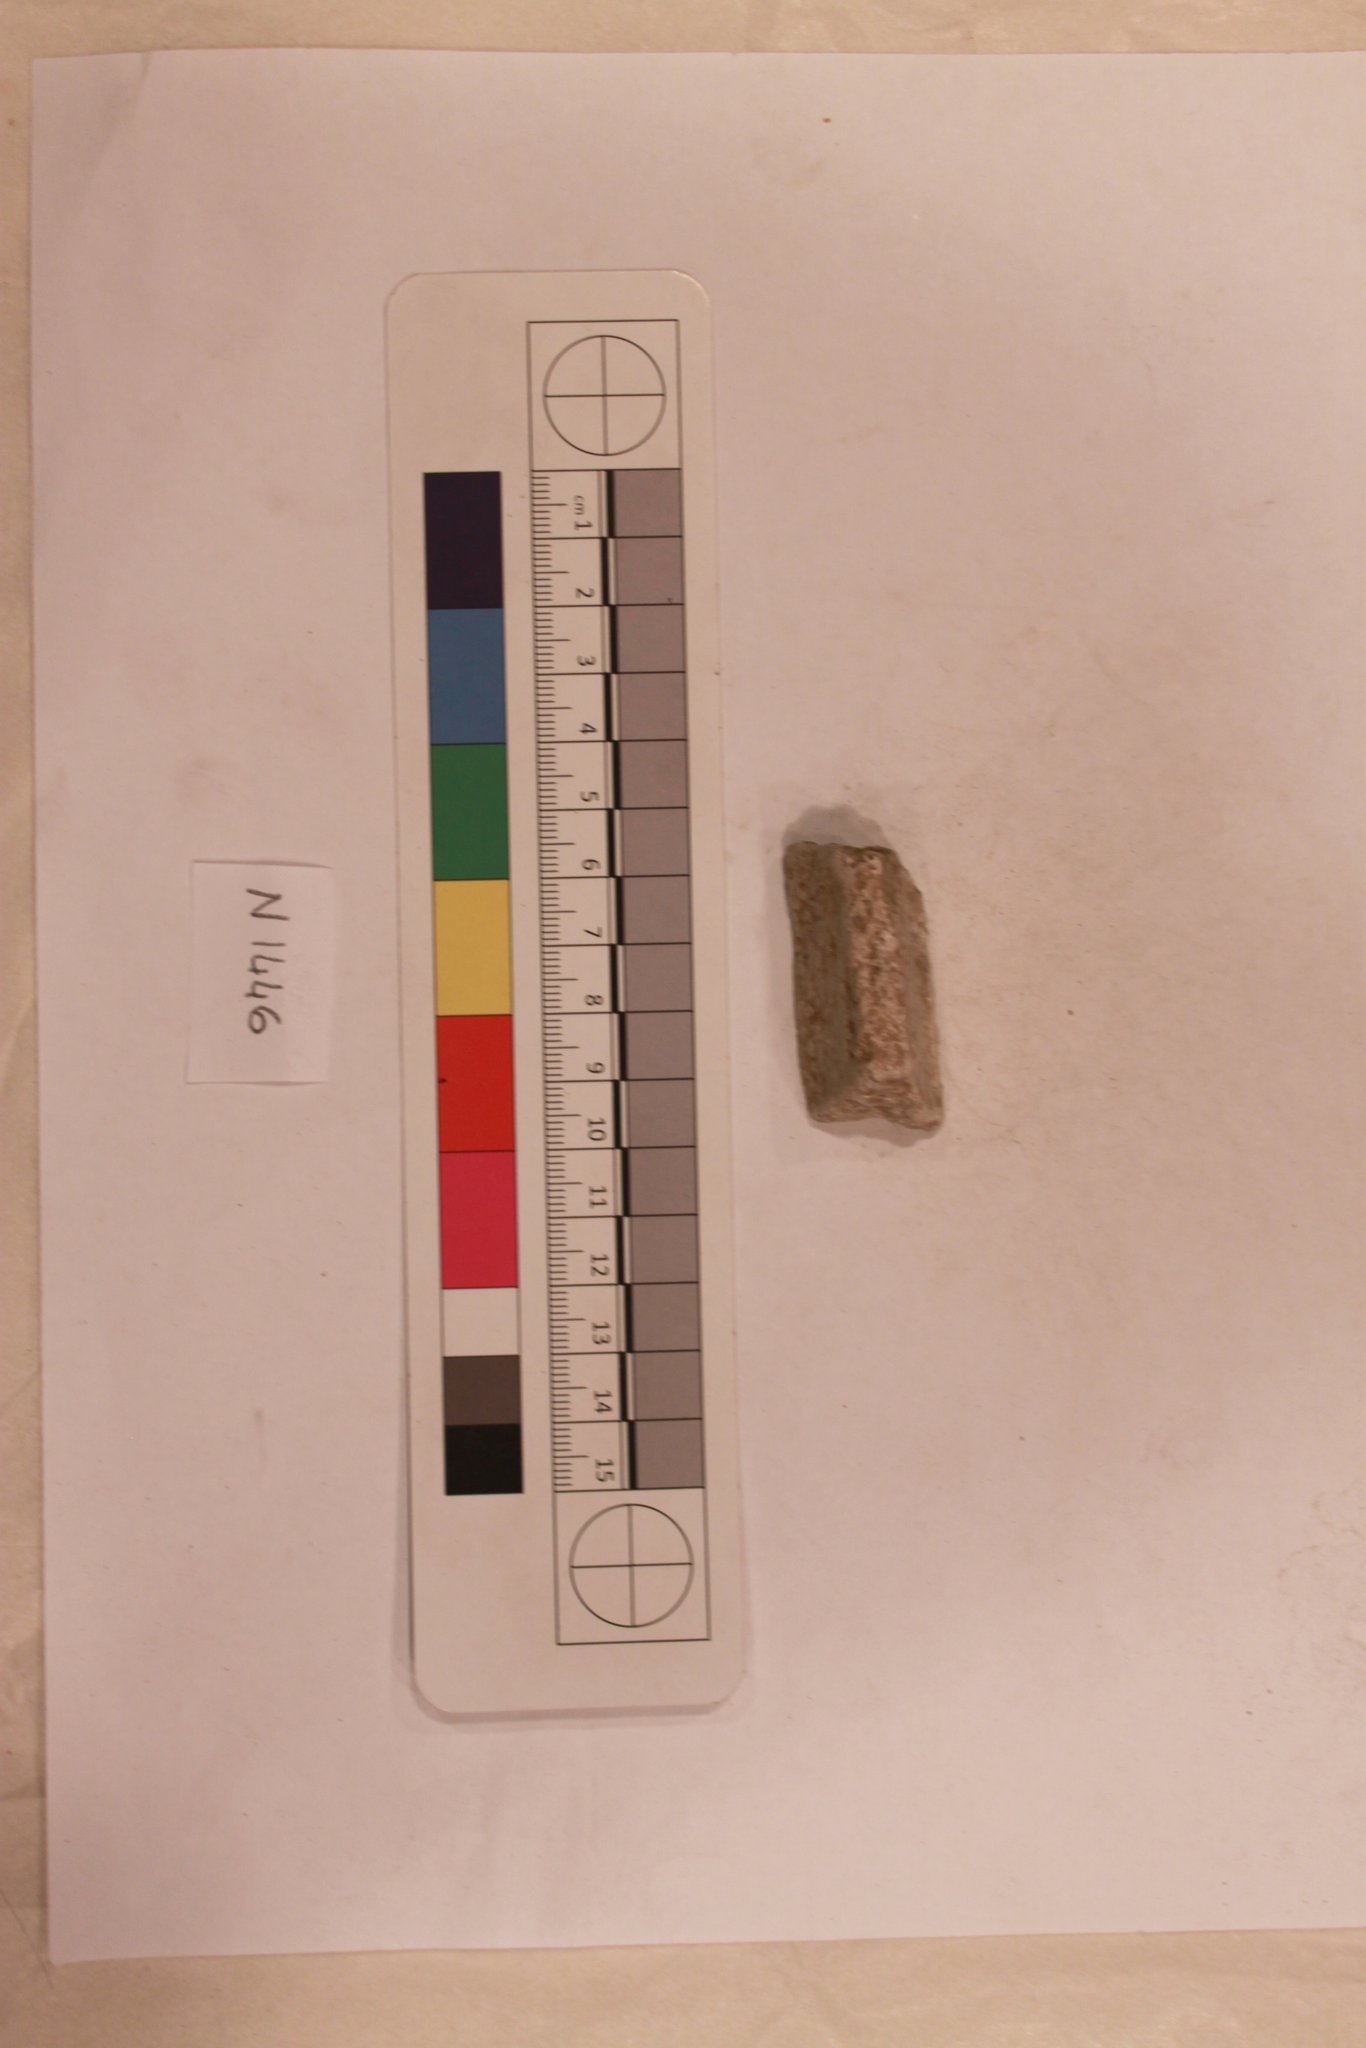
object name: fragment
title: Stucco Fragment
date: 701-1200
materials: plaster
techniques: carving, painting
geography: iran